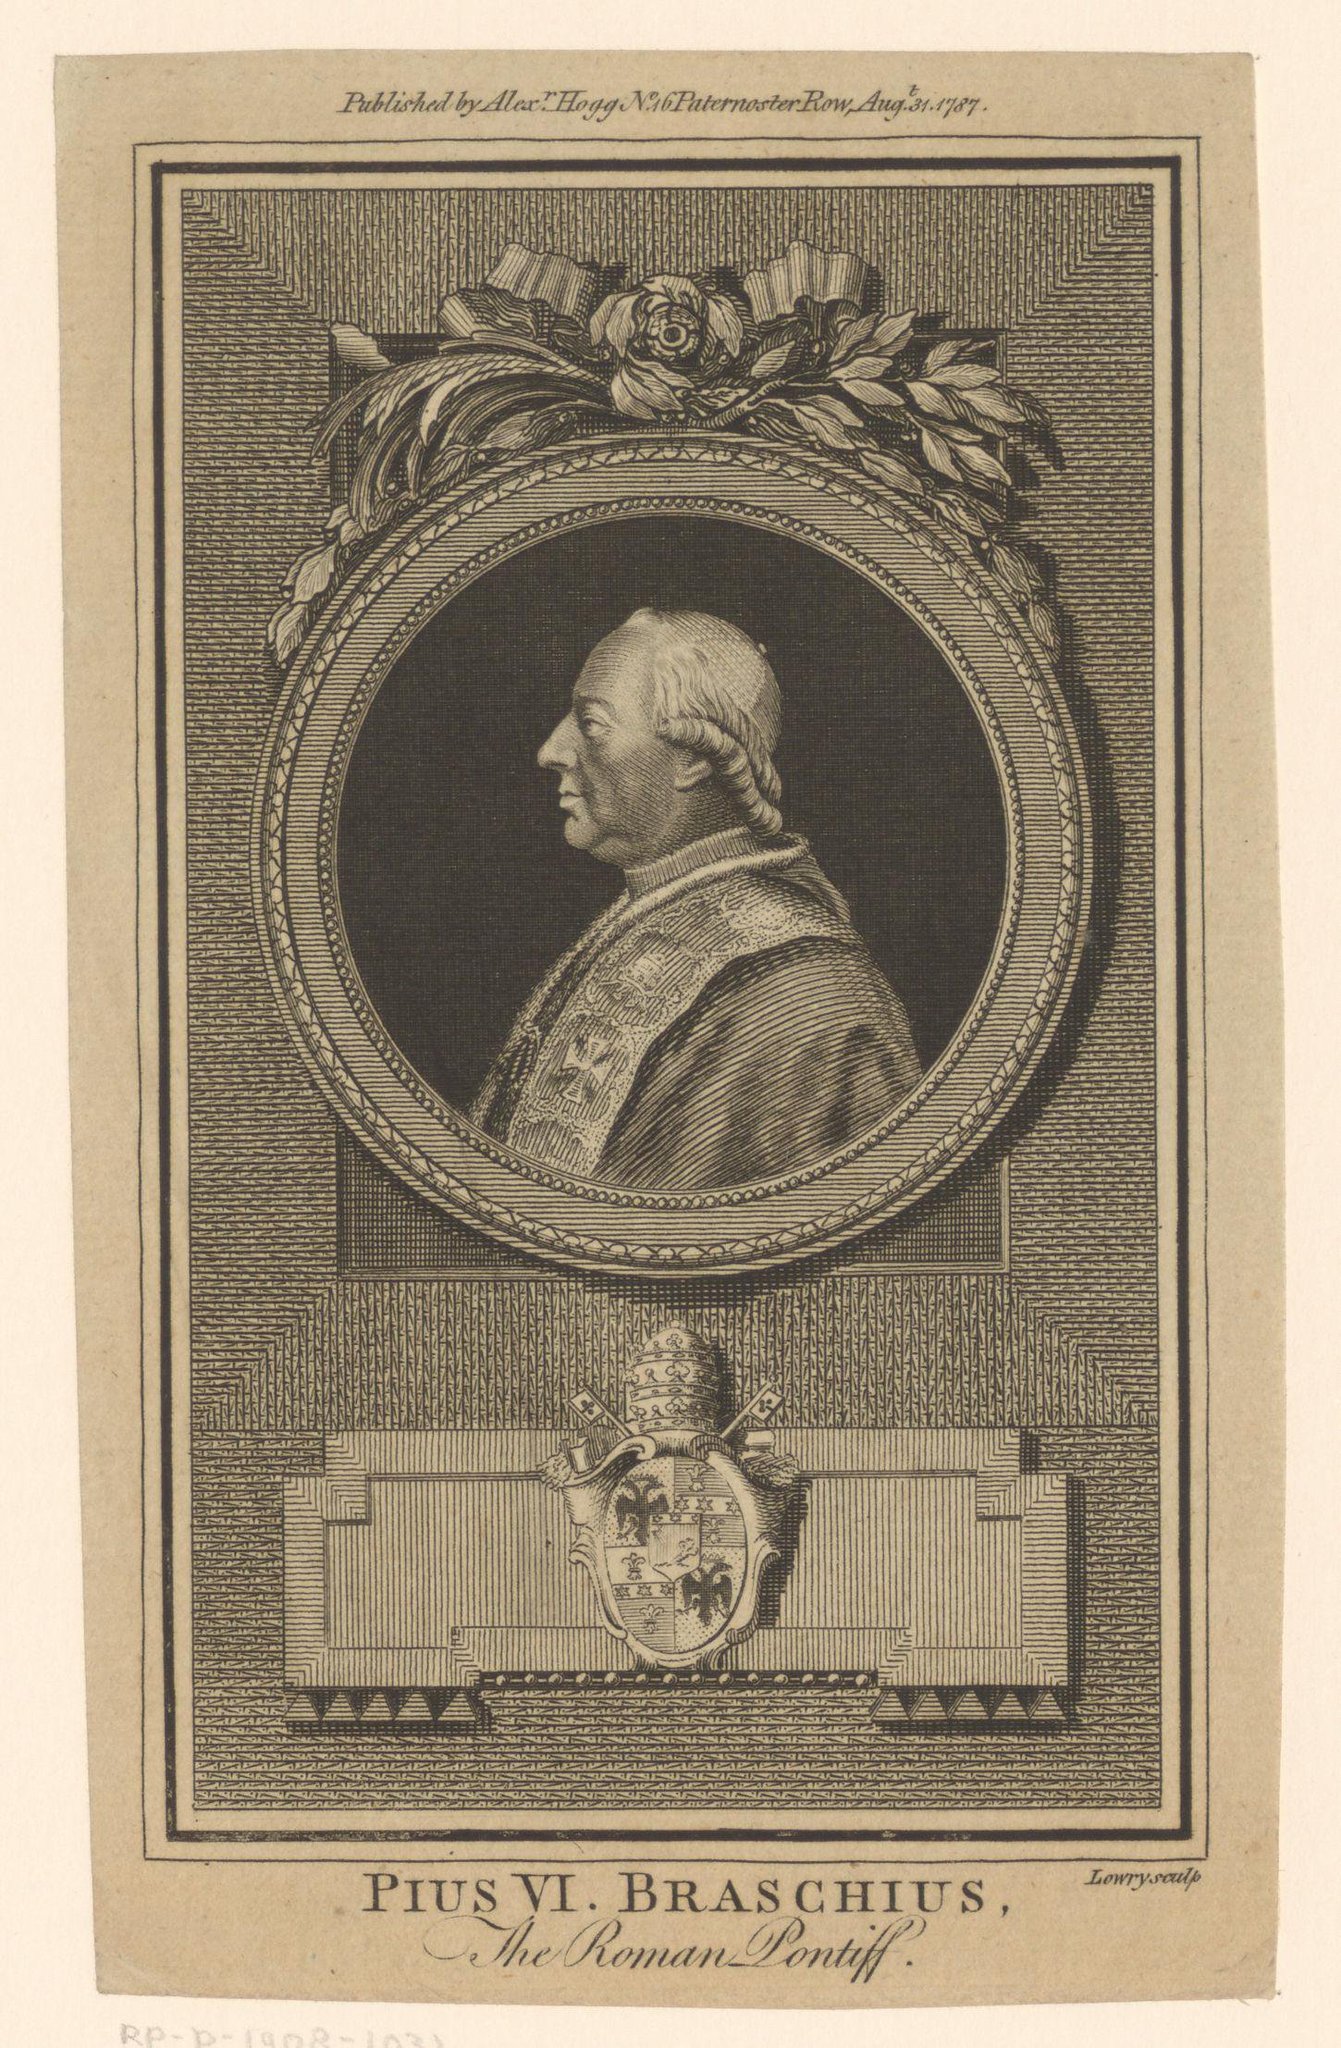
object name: print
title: Portret van paus Pius VI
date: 1787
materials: paper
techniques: engraving, etching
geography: london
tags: pius vi, historical persons, pope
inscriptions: collector's mark: Lugt 2228